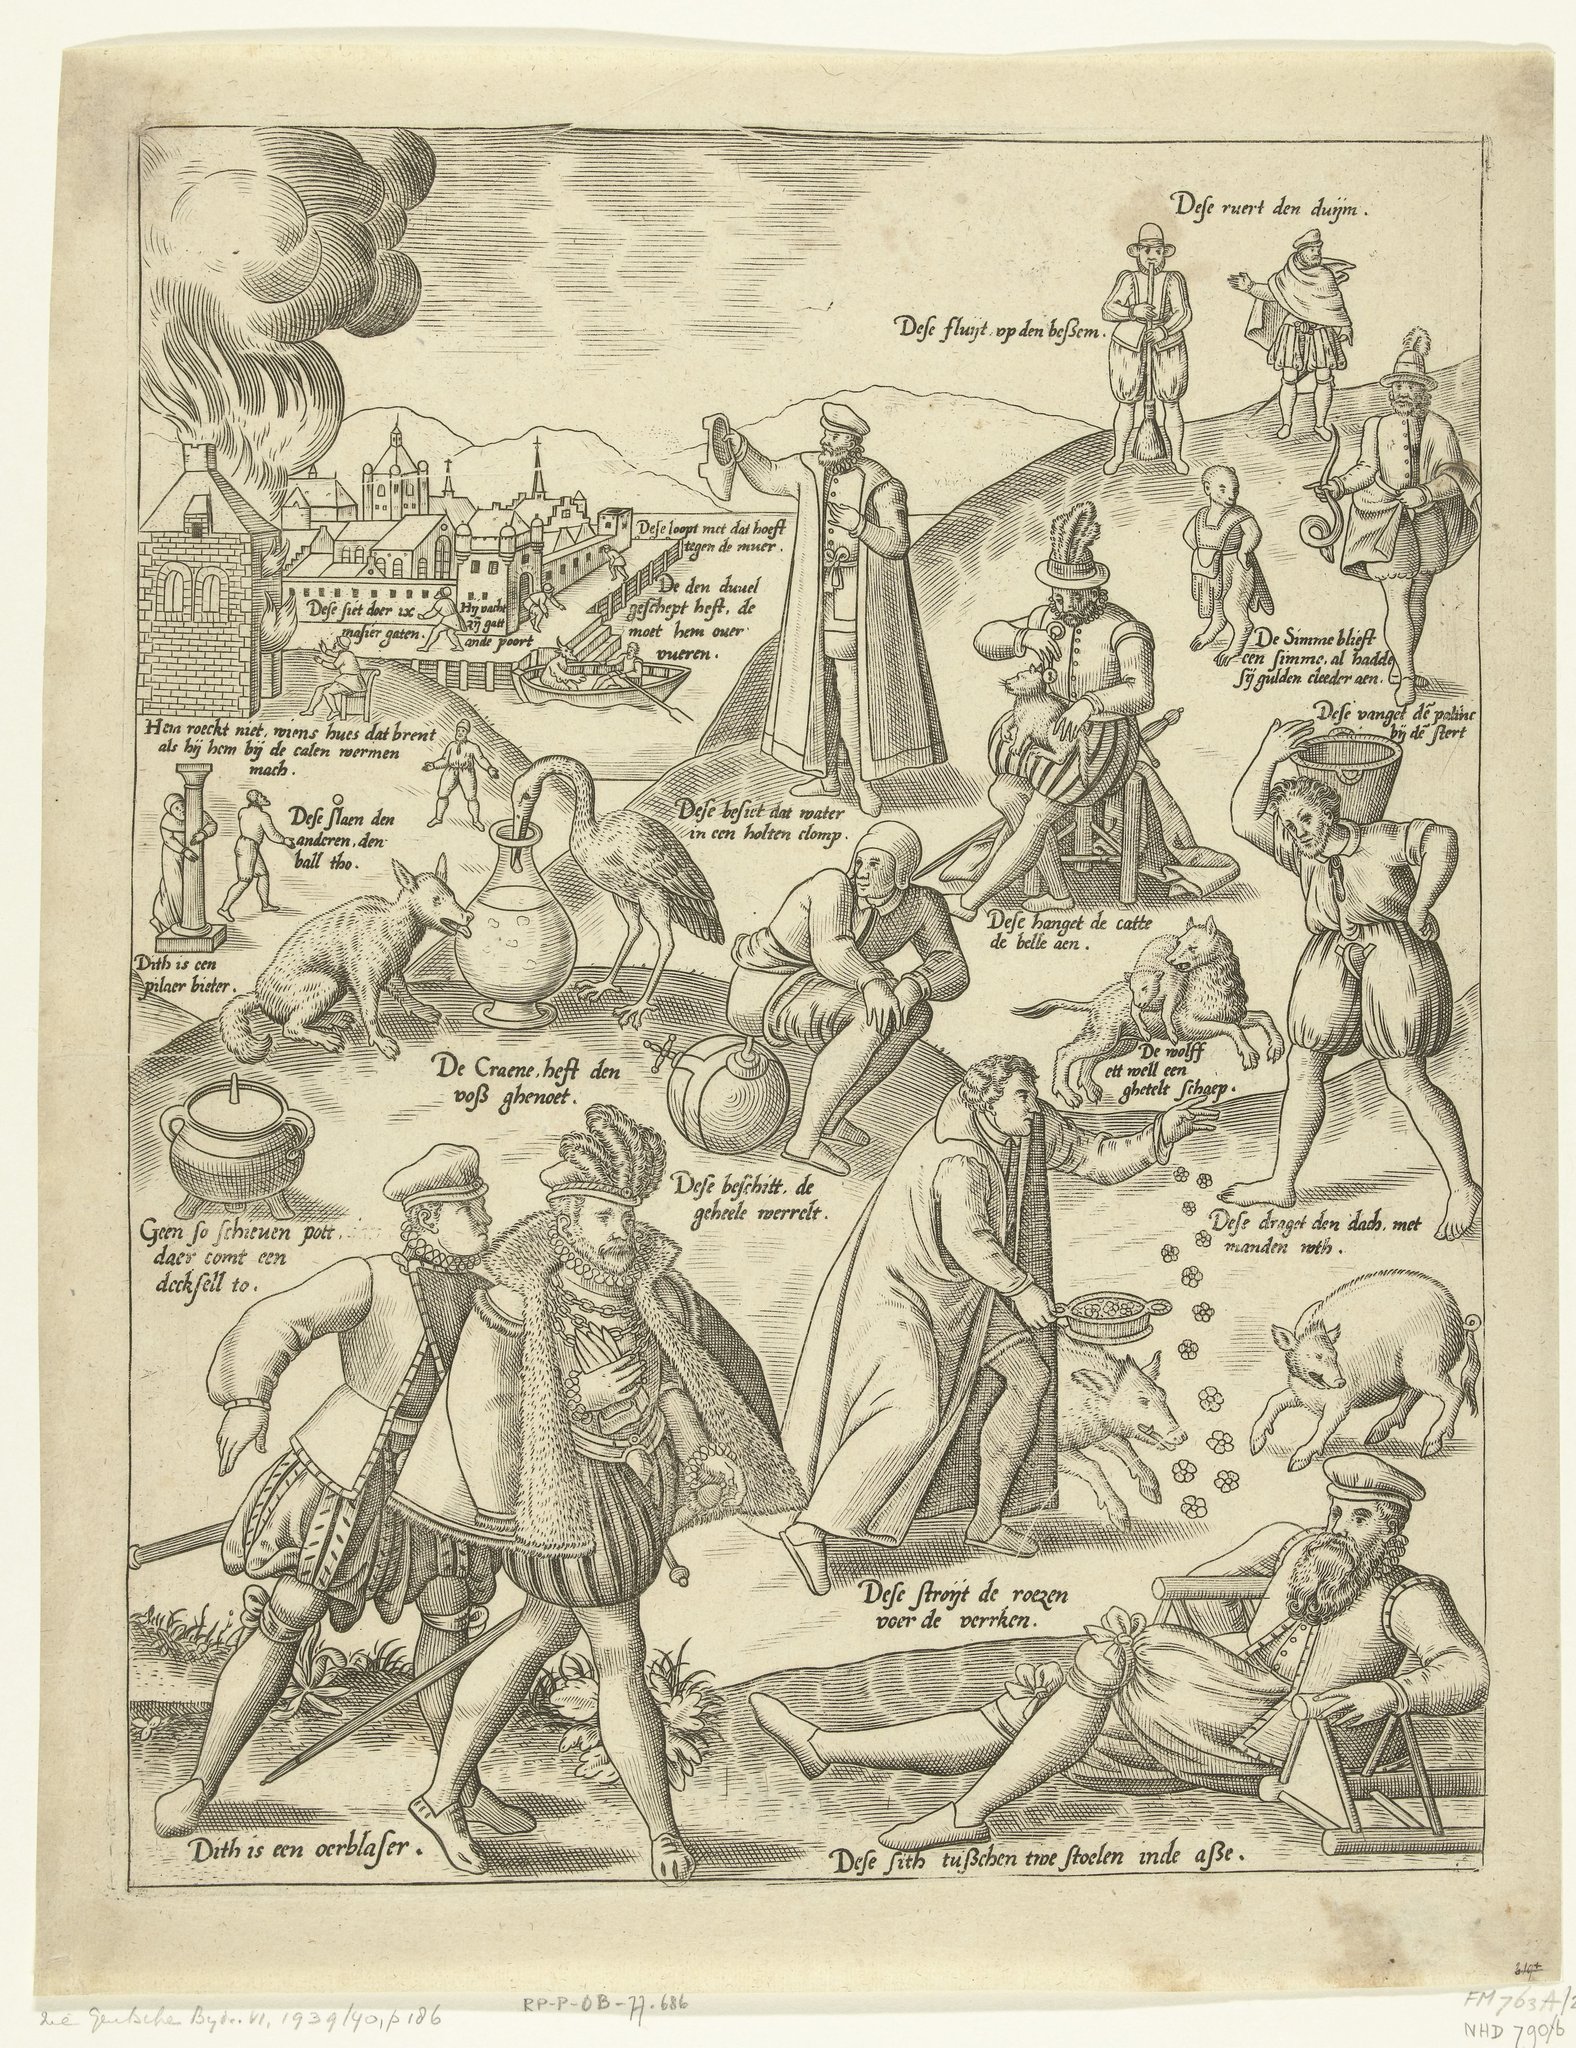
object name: print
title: De Blauwe Huyck (blad 2)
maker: joannes van doetechum (i)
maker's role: print maker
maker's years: 1528-1605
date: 1577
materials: paper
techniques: engraving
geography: low countries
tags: proverbs, sayings, etc.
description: zie: Gentsche Bijdragen VI, 1939-40, p. 186. Dit blad en het volgende (2 en 3) beschreven door Muller onder nummer FMH 3620. Beide prenten overgezet en gevoegd bij de twee bijbehorende platen (1 en 4) beschreven onder nummer 763A